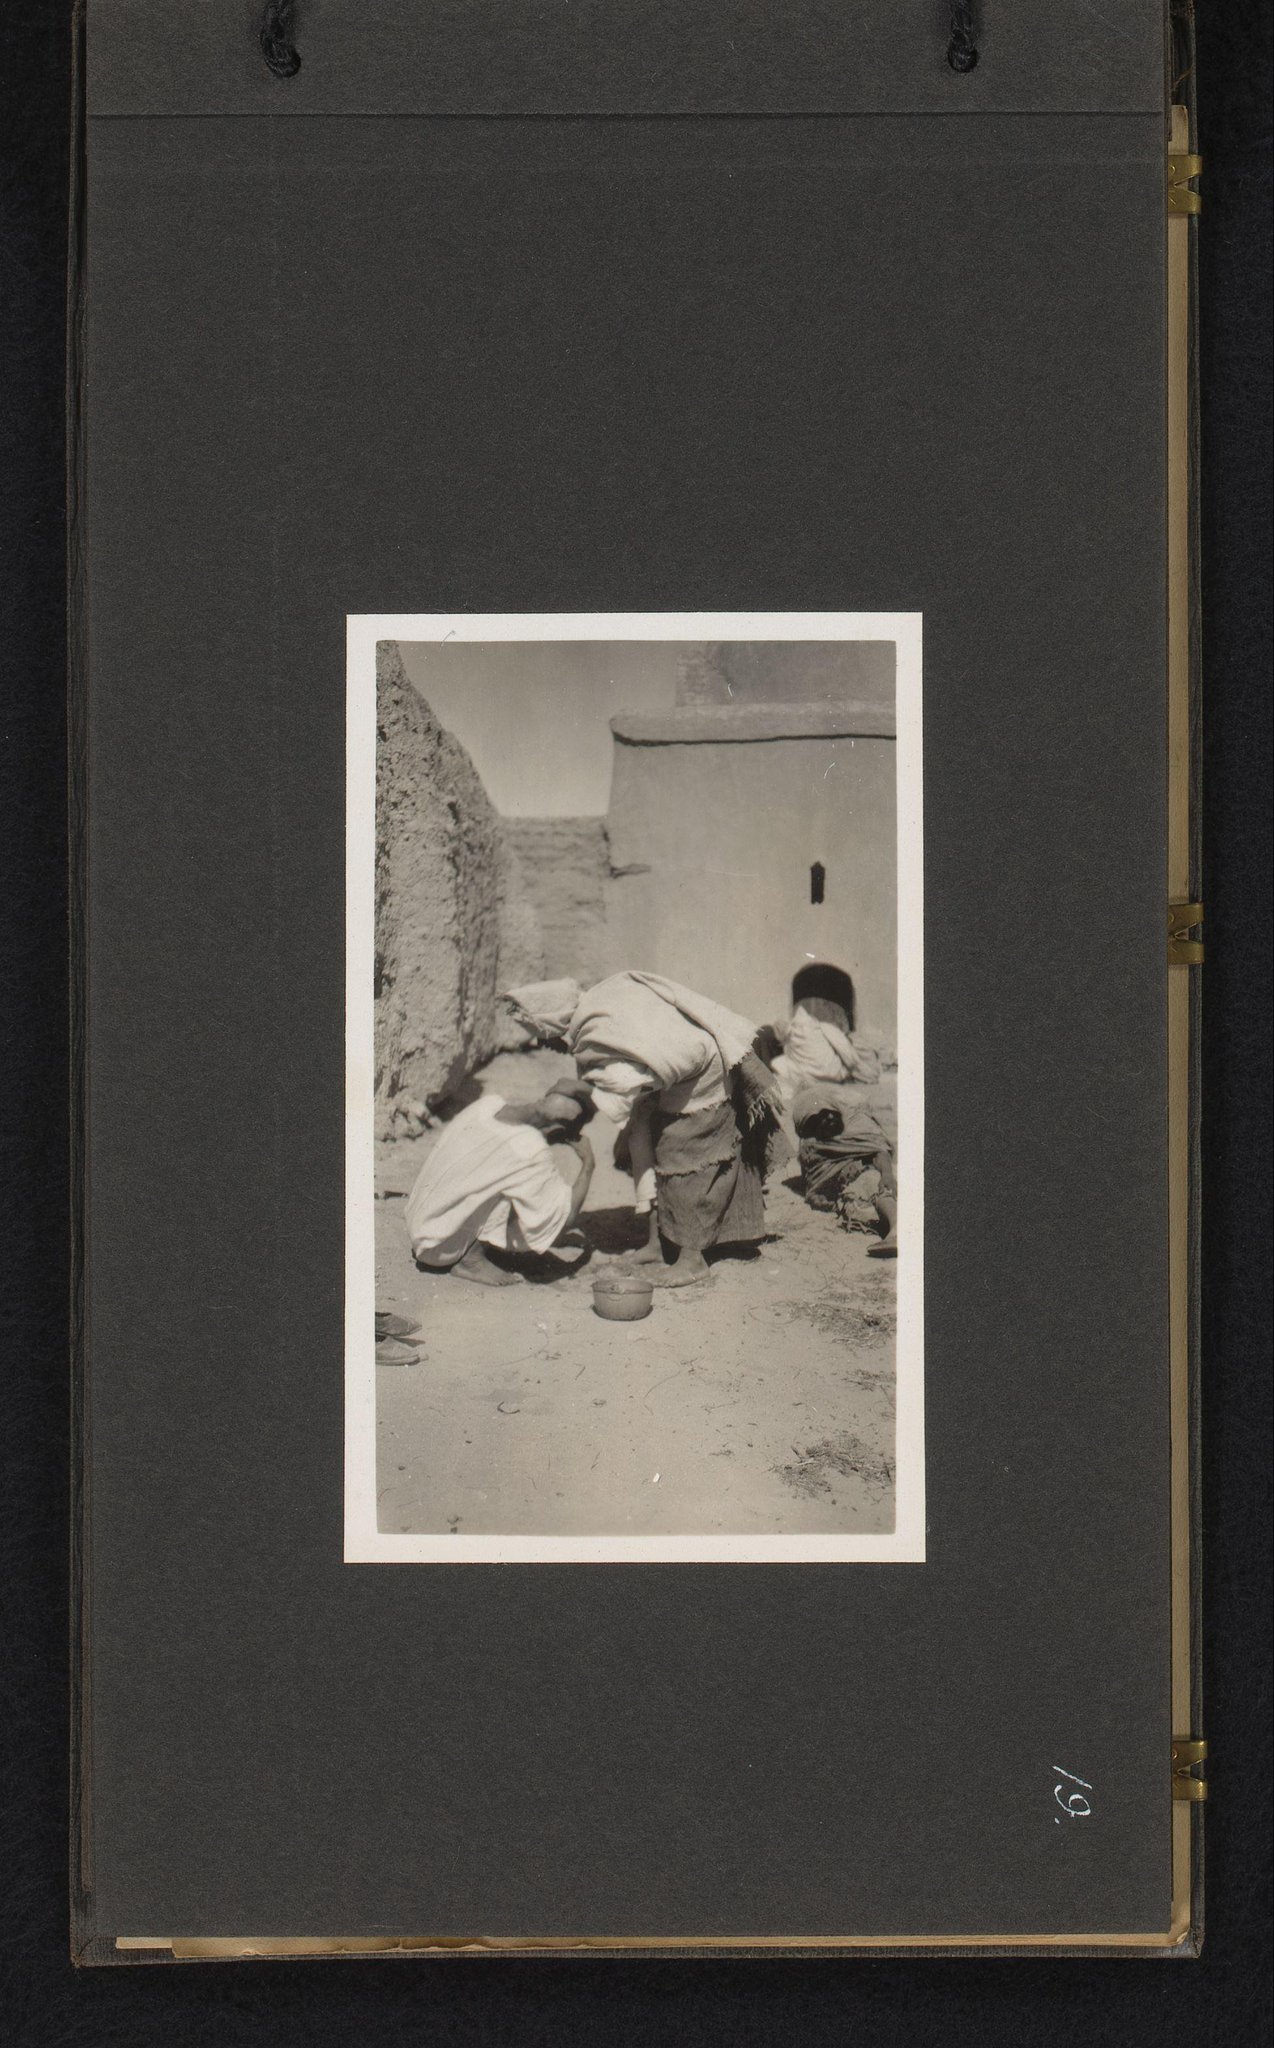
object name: album leaf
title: Persoon die geschoren wordt, Le Figuig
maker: a.g.a. van eelde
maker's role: engineer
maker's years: 1862-1950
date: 1927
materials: paper, photographic support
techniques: gelatin silver print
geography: figuig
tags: shaving, being shaved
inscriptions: number: ‘19.’